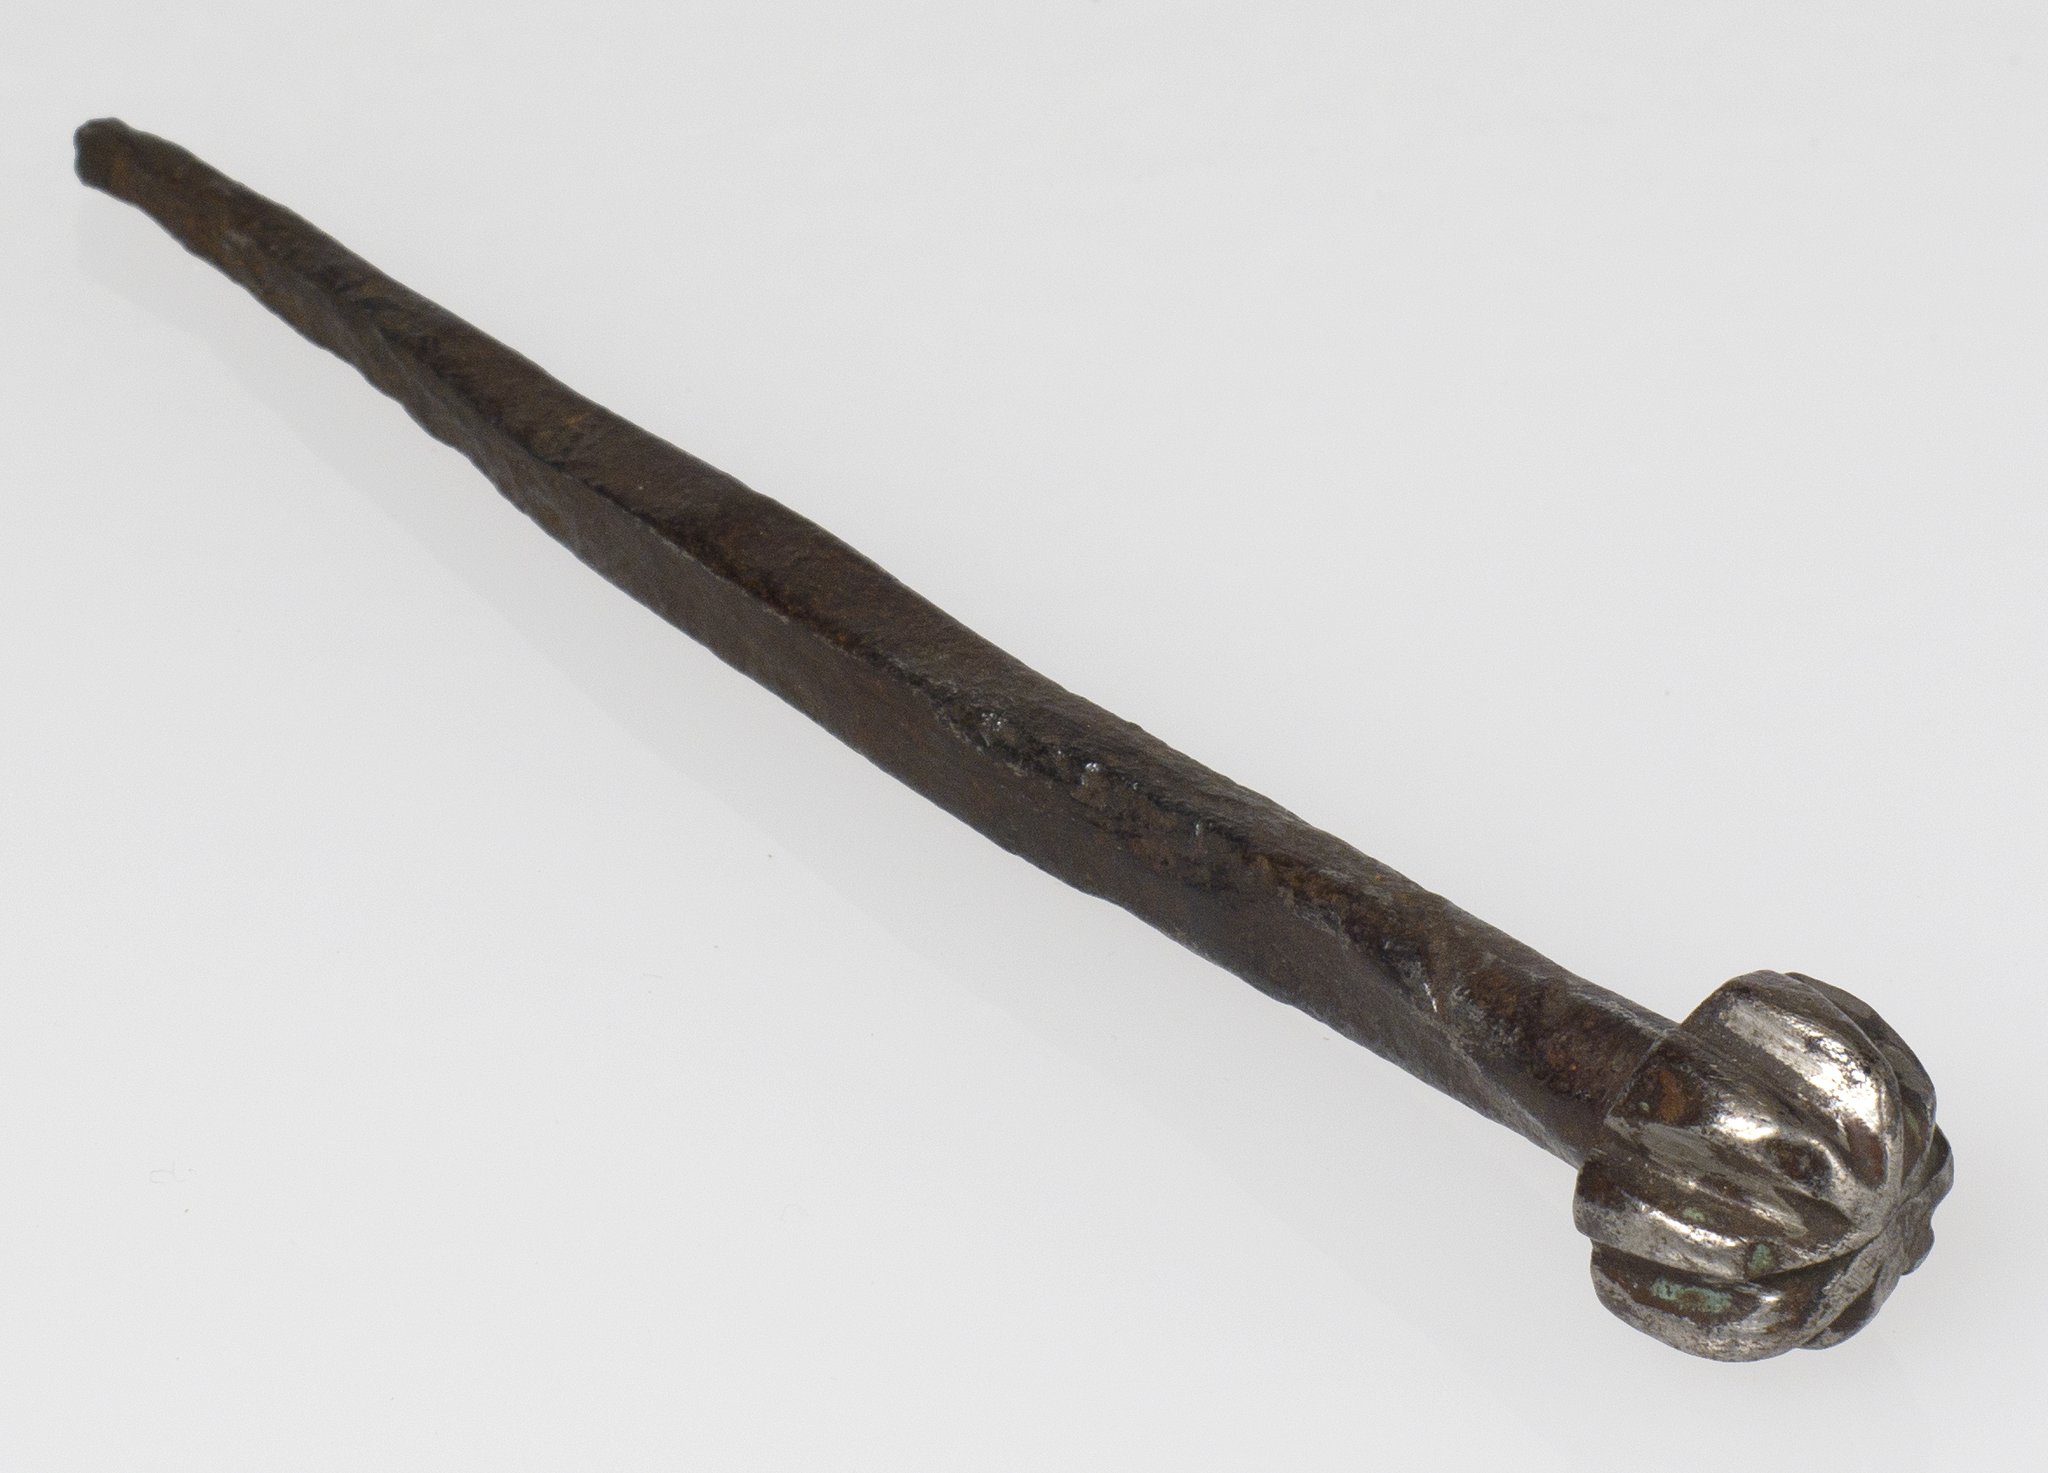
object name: nail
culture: european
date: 1401-1600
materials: iron